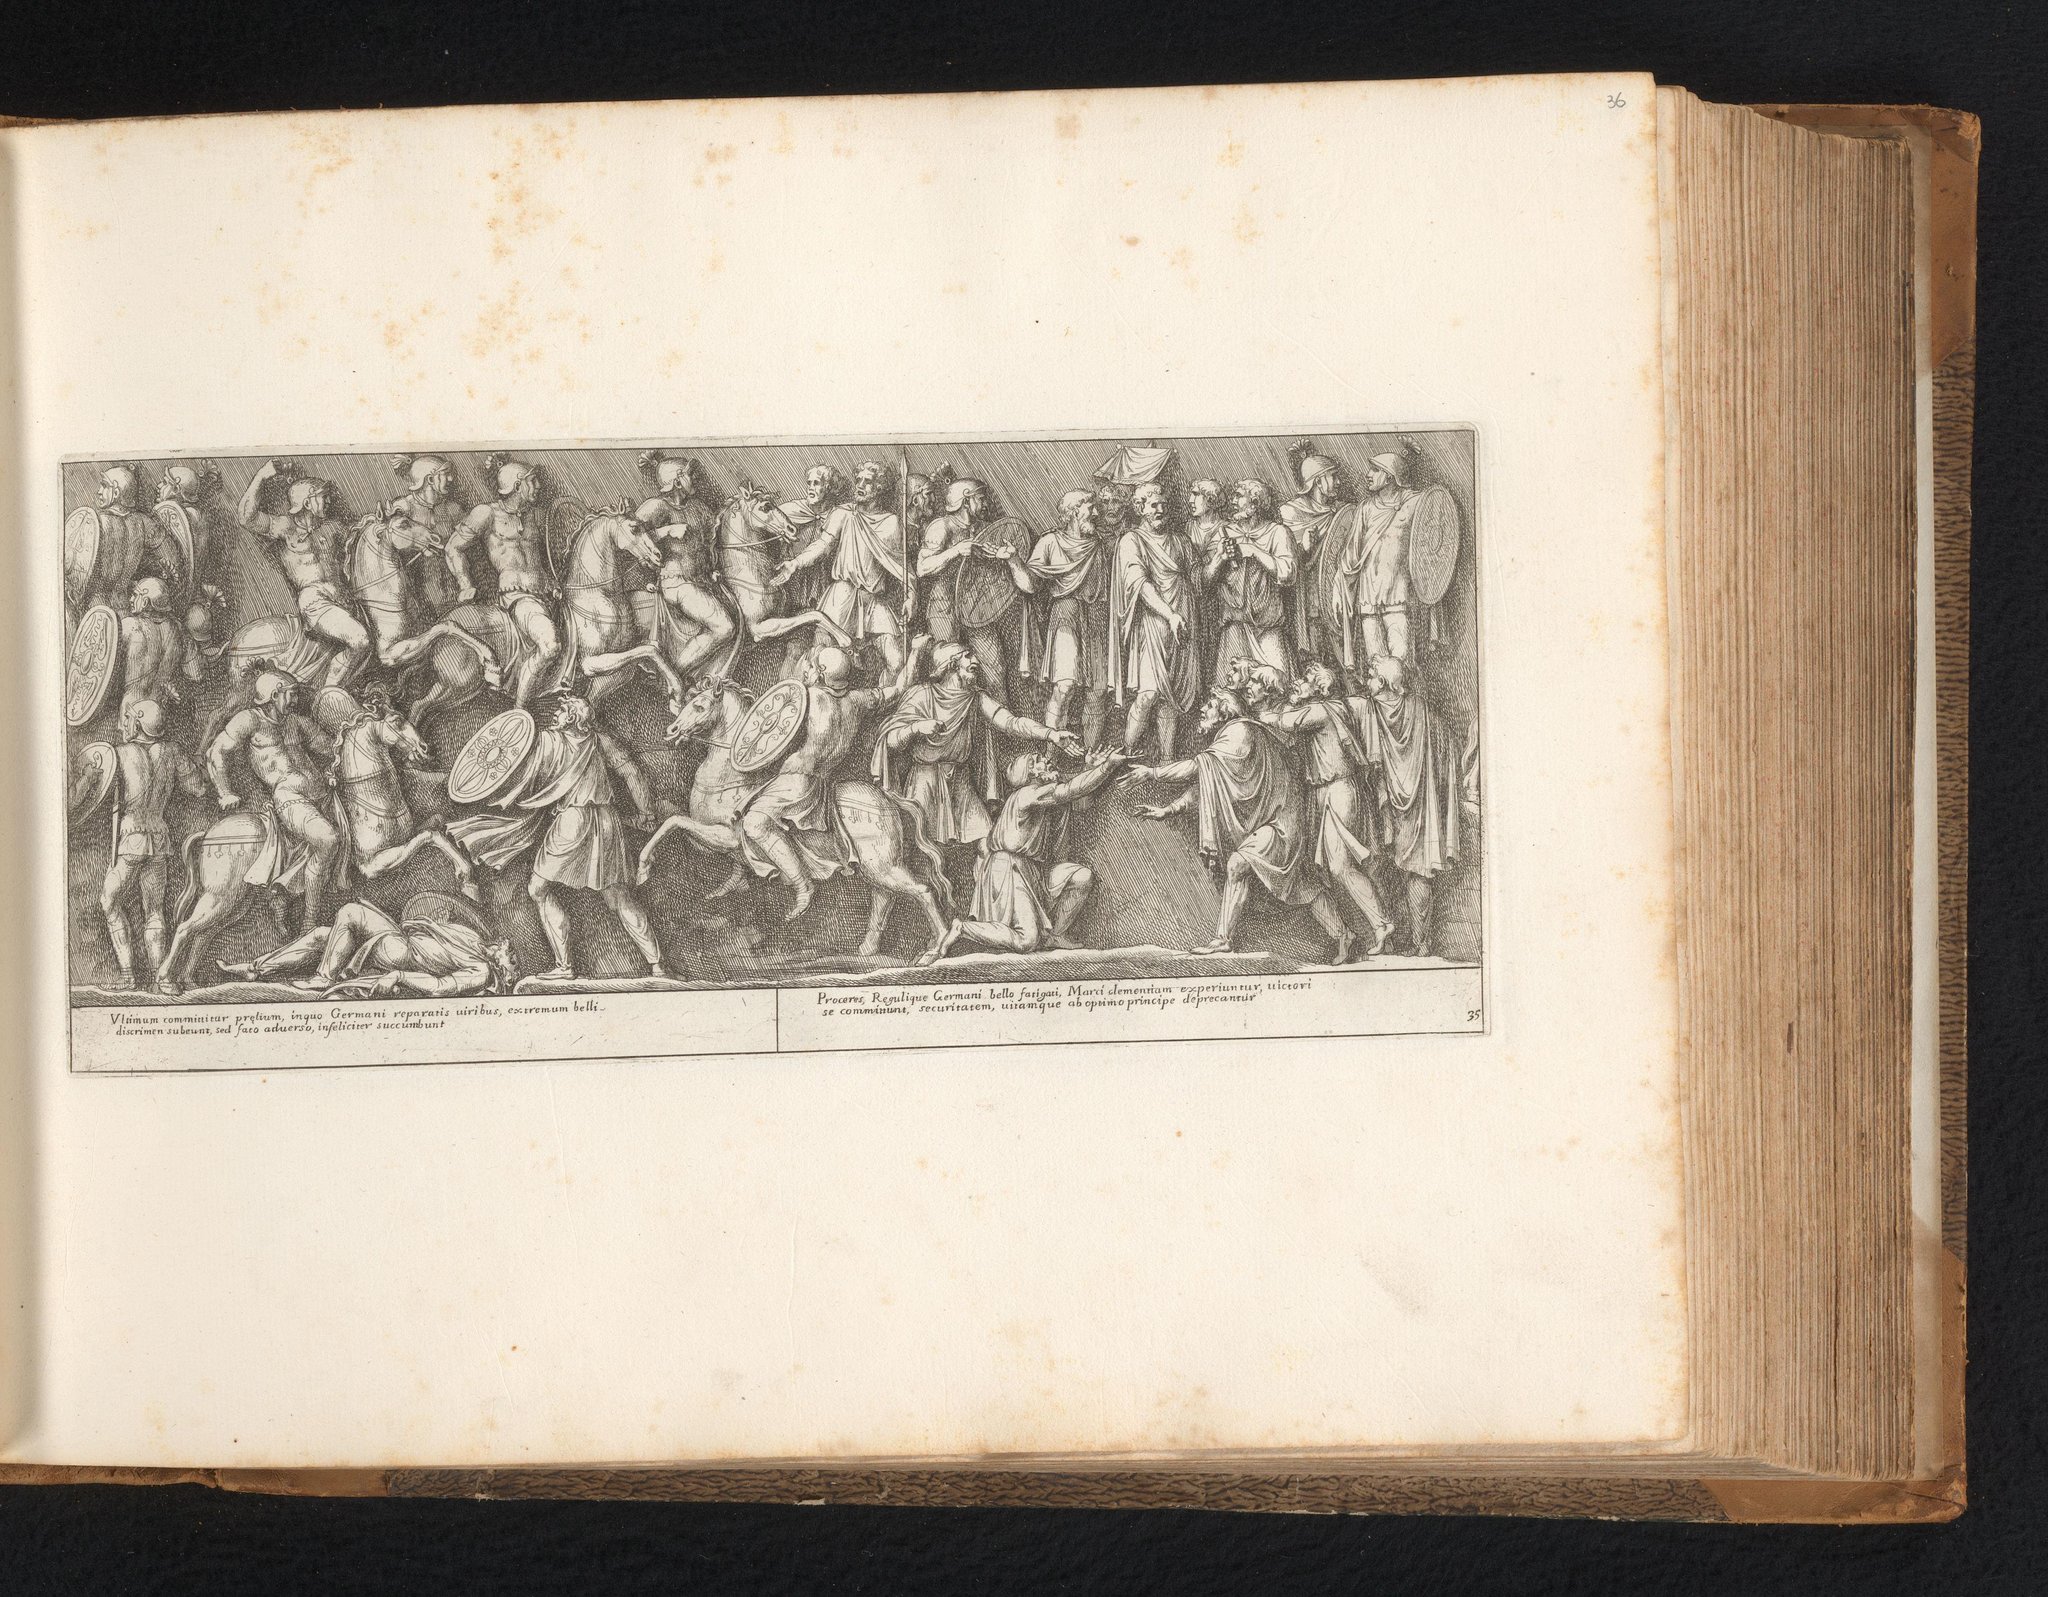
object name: album leaf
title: Zuil van Marcus Aurelius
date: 1672-1675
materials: paper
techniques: etching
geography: rome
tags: triumphal column with helical friezes, piece of sculpture, reproduction of a piece of sculpture, the soldier; the soldier's life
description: Detail van het spiraalvormige gebeeldhouwde fries op de Zuil van Marcus Aurelius te Rome. Het fries toont de oorlog tussen het Romeinse leger van keizer Marcus Aurelius en de Germaanse stammen der Marcomannen en Quaden en de oorlog tegen de Sarmaten die vanuit het huidige Iran Hongarije waren binnengevallen. Tekst in de ondermarge. Prent maakt deel uit van een album.